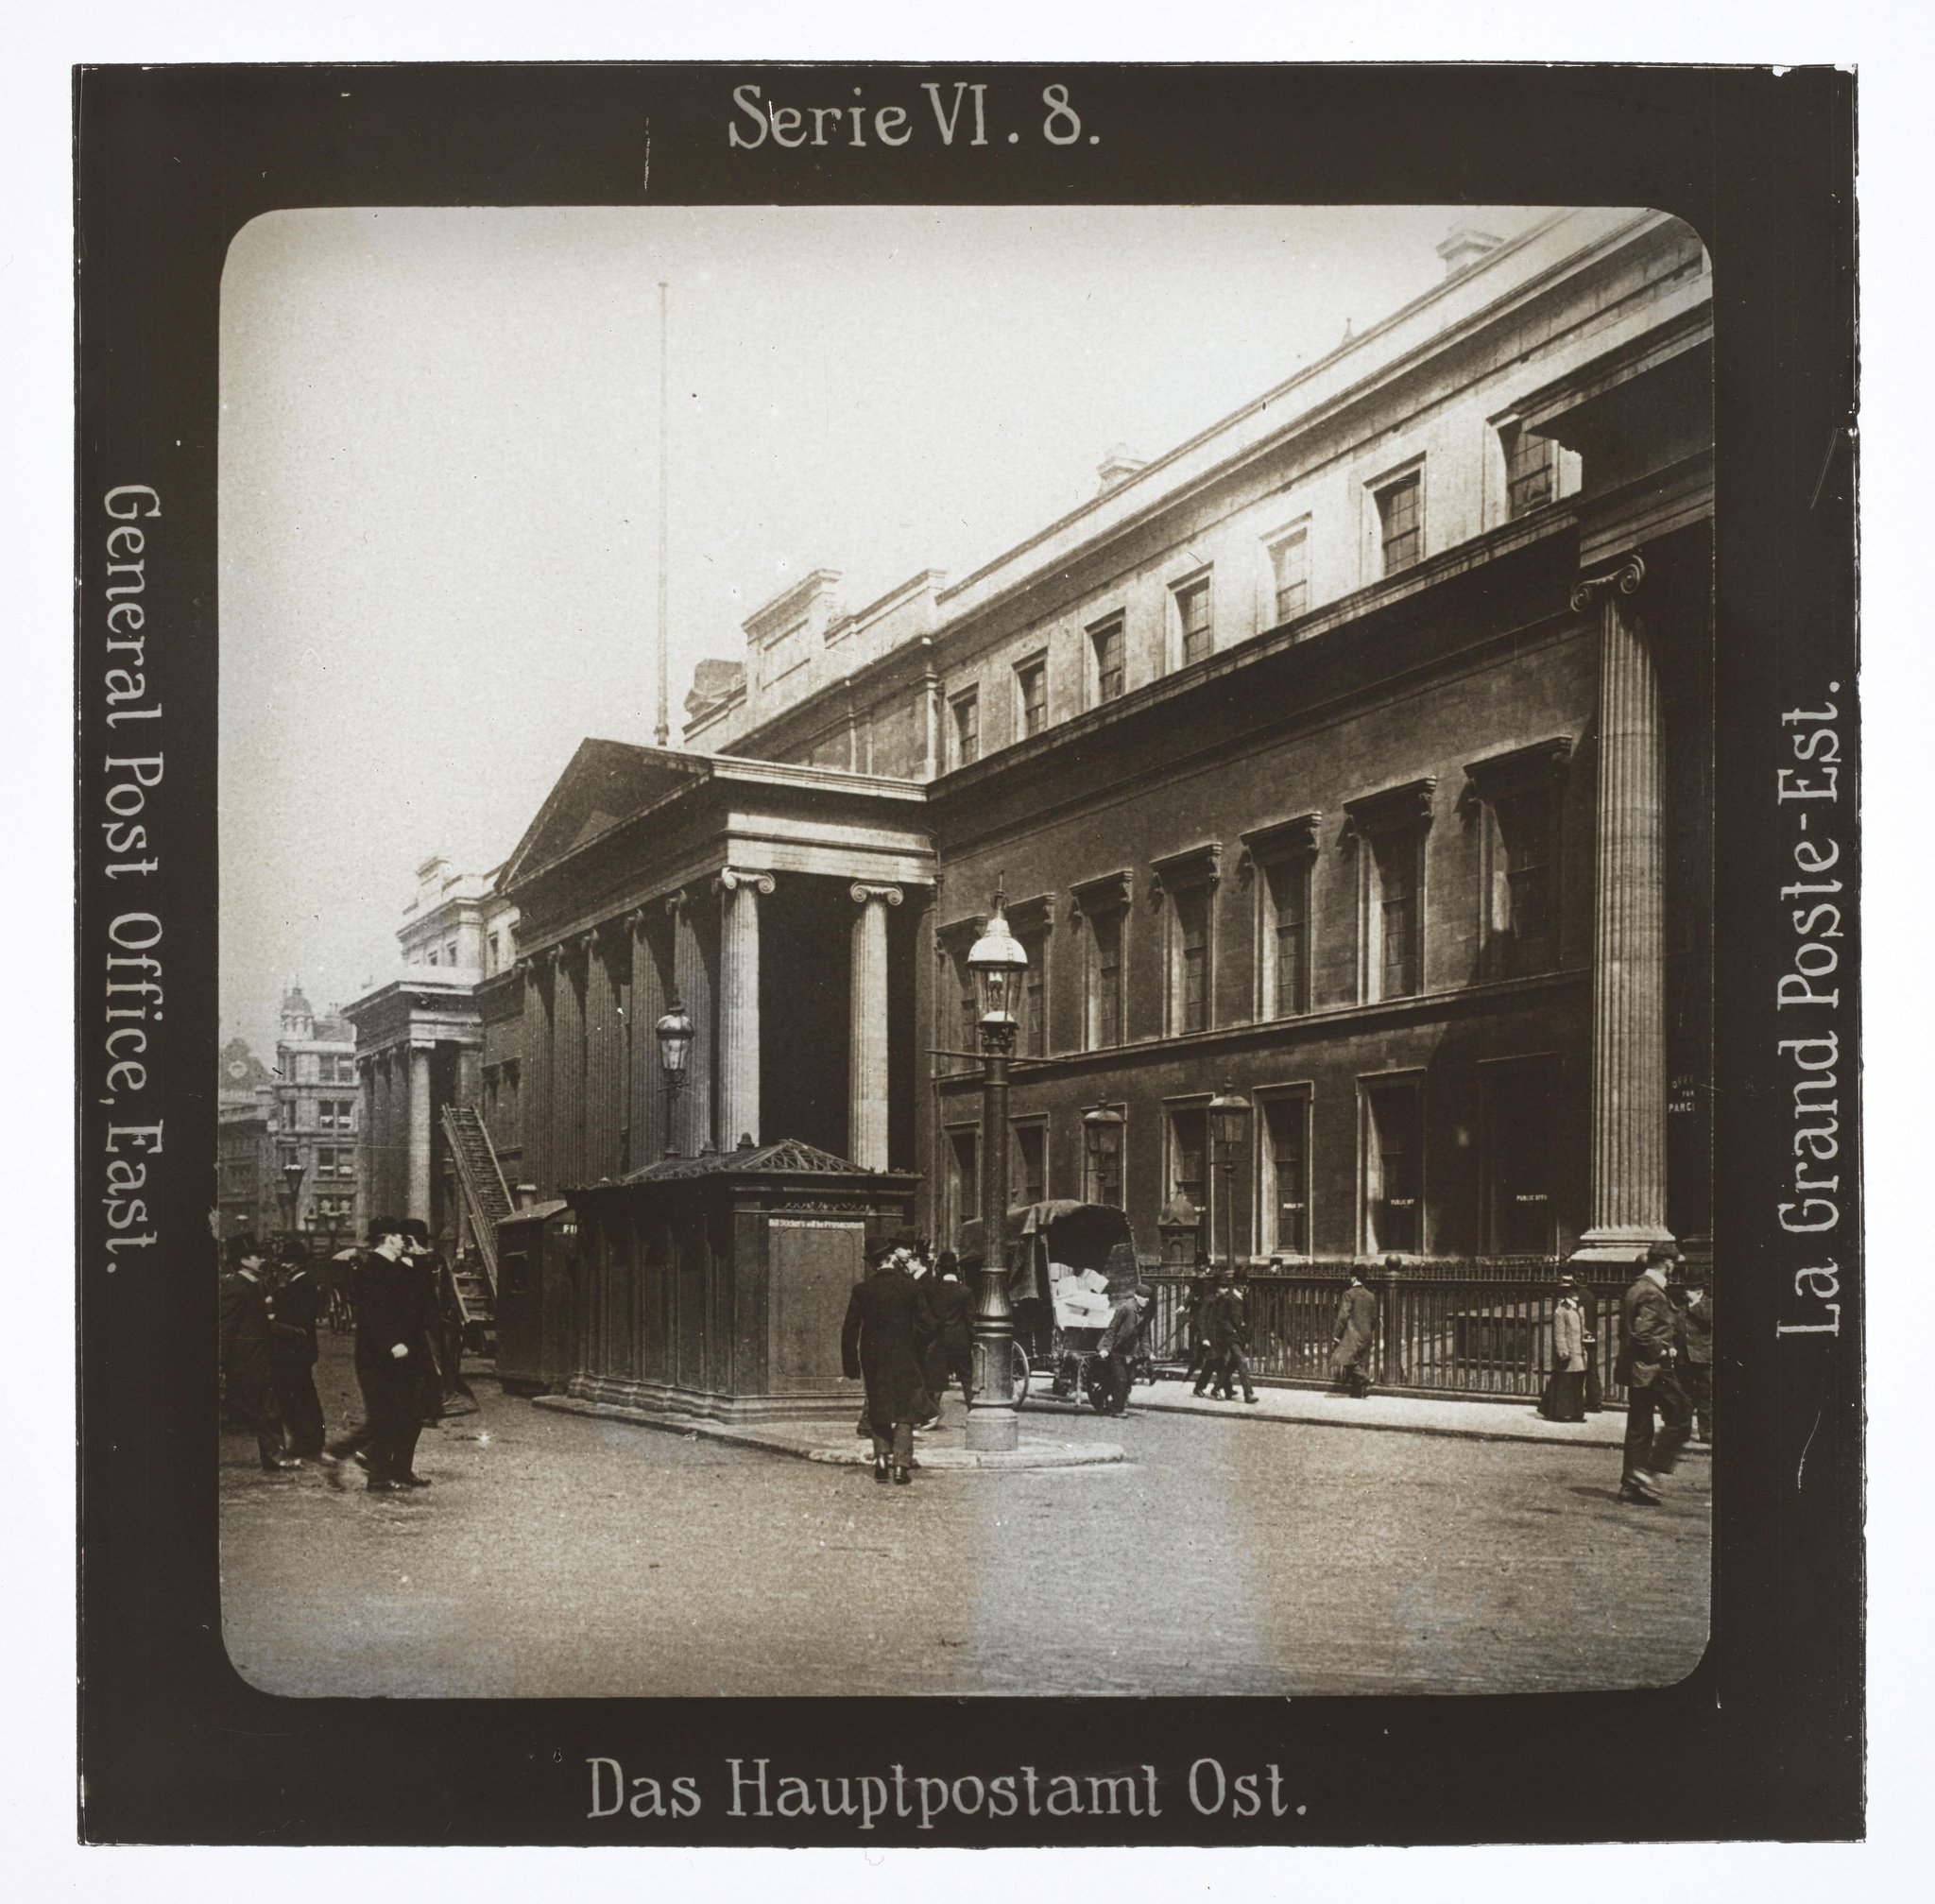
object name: lantern slide photographic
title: Gezicht op de General Post Office te Londen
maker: Anonymous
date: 1900-1906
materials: glass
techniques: gelatin silver transparency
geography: germany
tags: post-office, street